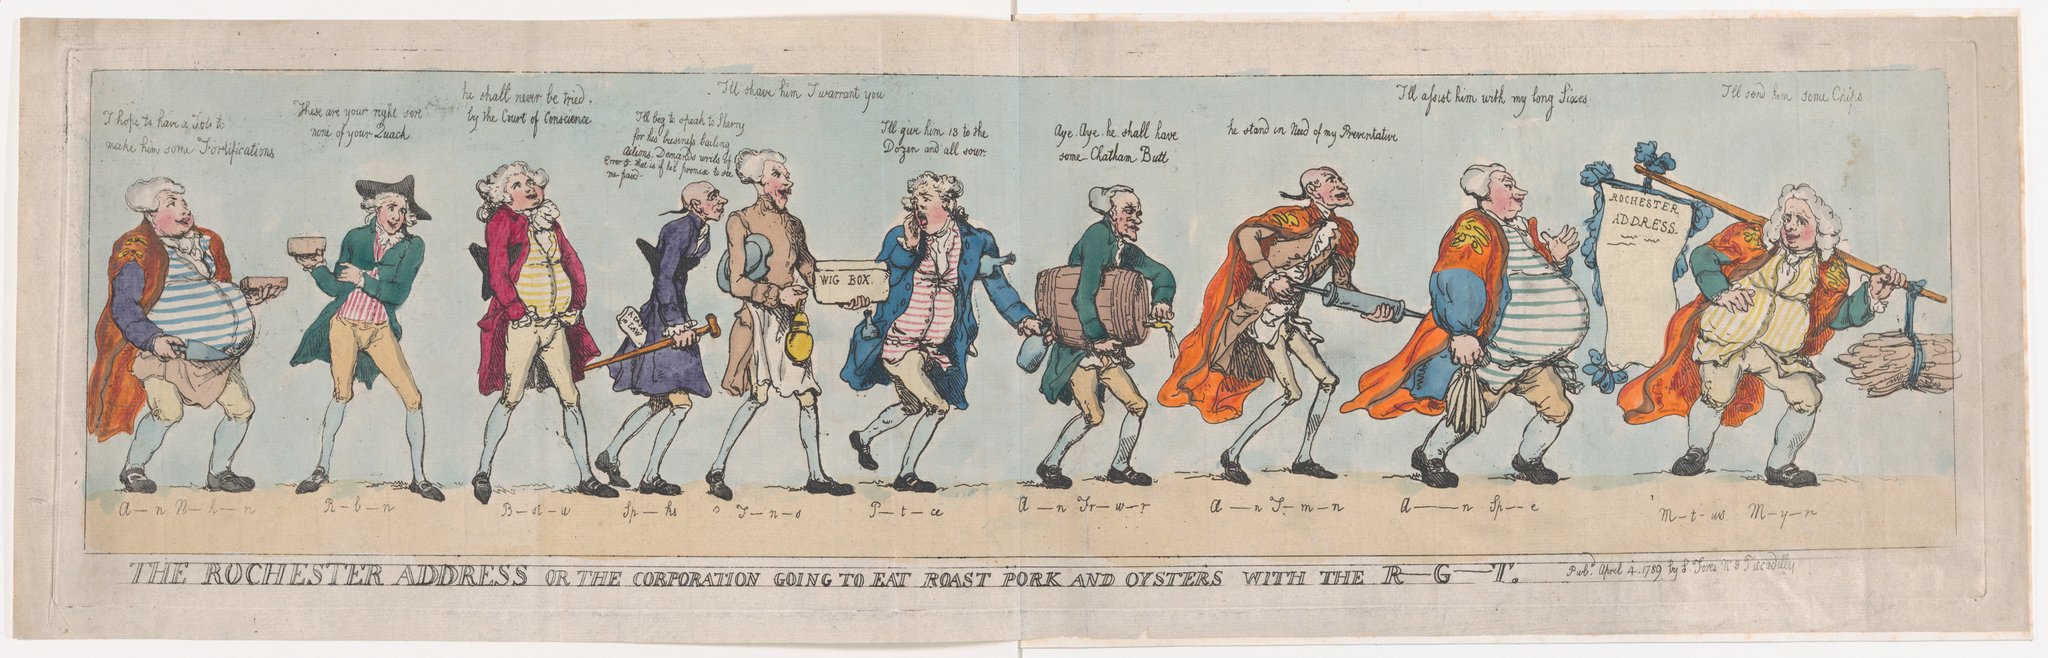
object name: print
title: The Rochester Address or The Corporation Going To Eat Roast Pork and Oysters with the R-G-T.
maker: thomas rowlandson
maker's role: artist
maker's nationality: british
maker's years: 1757-1827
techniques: etching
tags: satire,men,processions